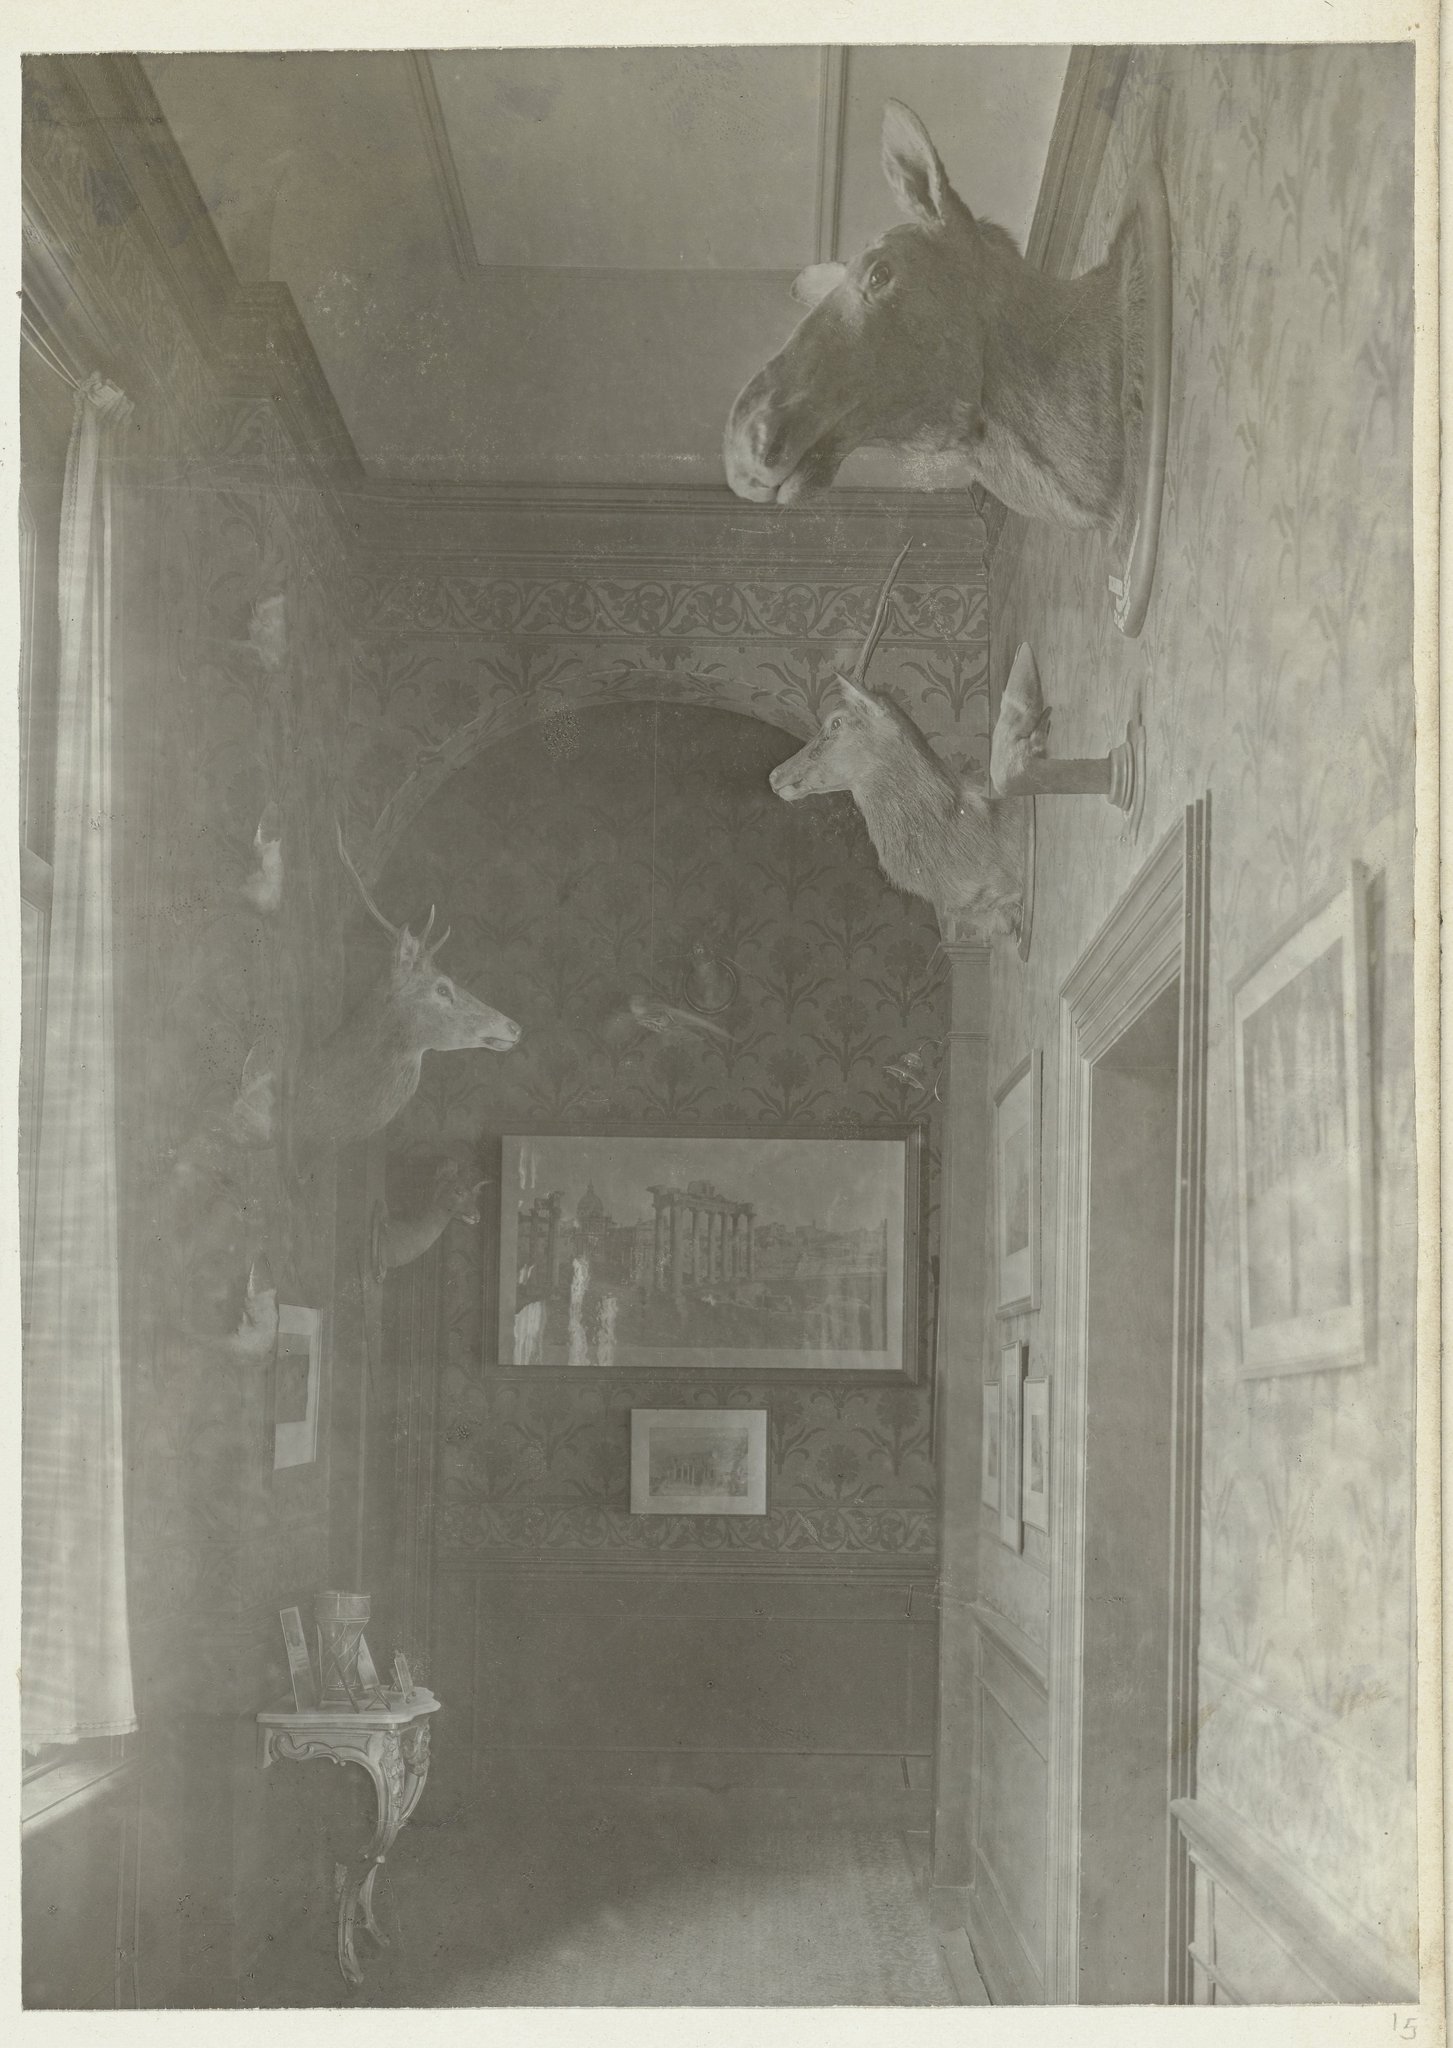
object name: photograph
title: Hal van landhuis De Wildbaan, Driebergen, met jachttrofeeën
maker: henry pauw van wieldrecht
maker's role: fotograaf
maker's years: 1863-1912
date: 1903-1907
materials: paper, photographic support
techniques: gelatin silver print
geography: netherlands